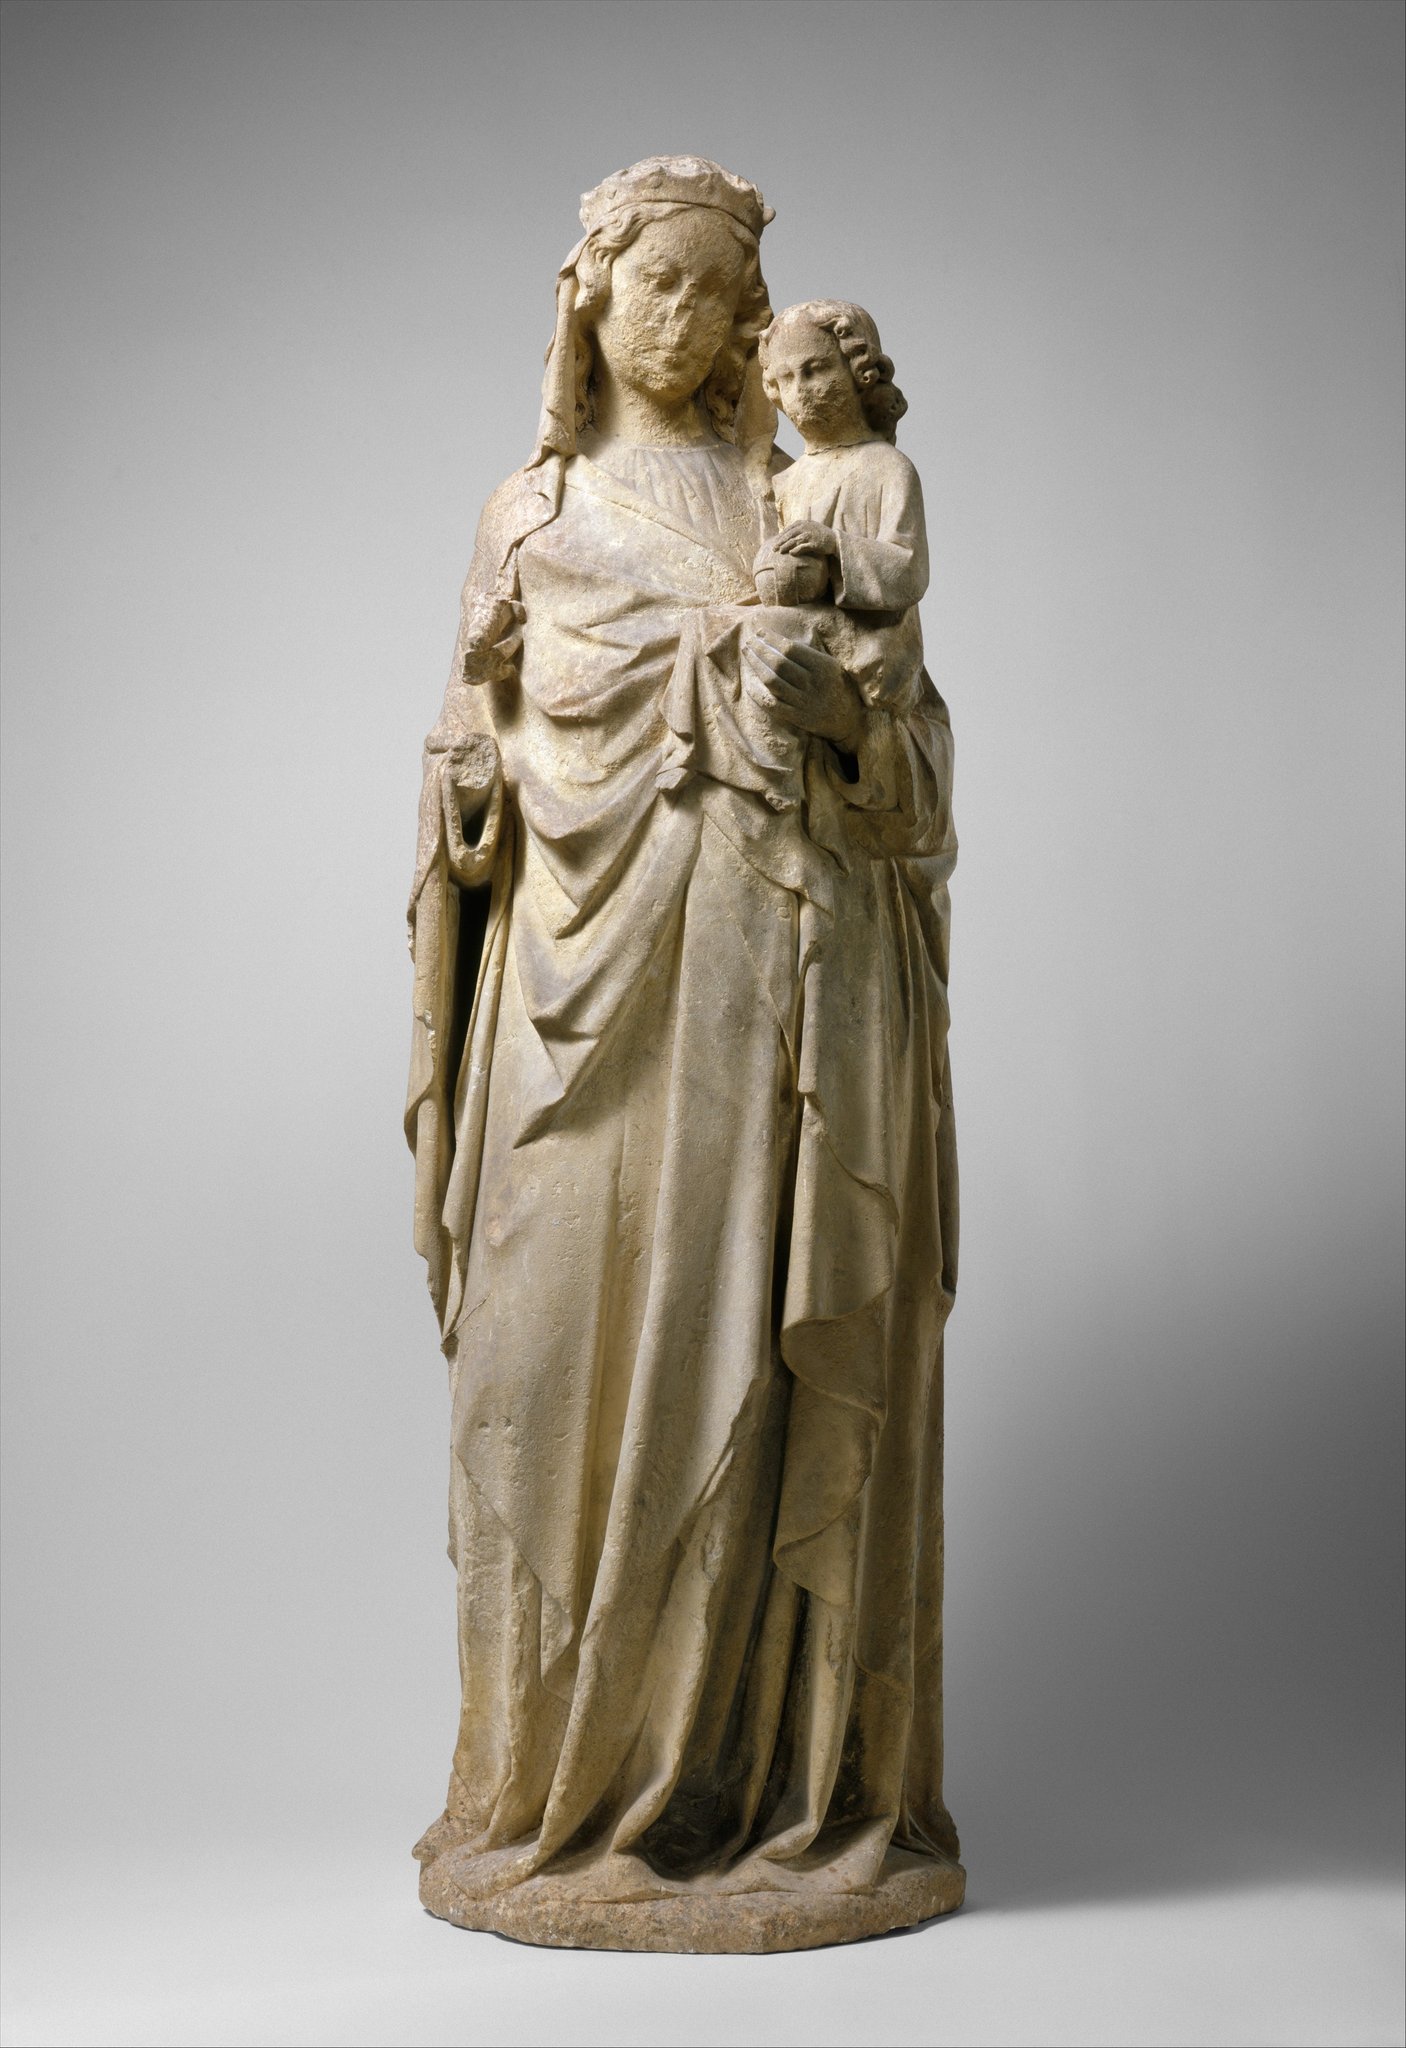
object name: statue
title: Virgin and Child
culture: british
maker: alexander of abingdon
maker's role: artist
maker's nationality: british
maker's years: 1250-1350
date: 1275-1325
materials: limestone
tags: madonna and child